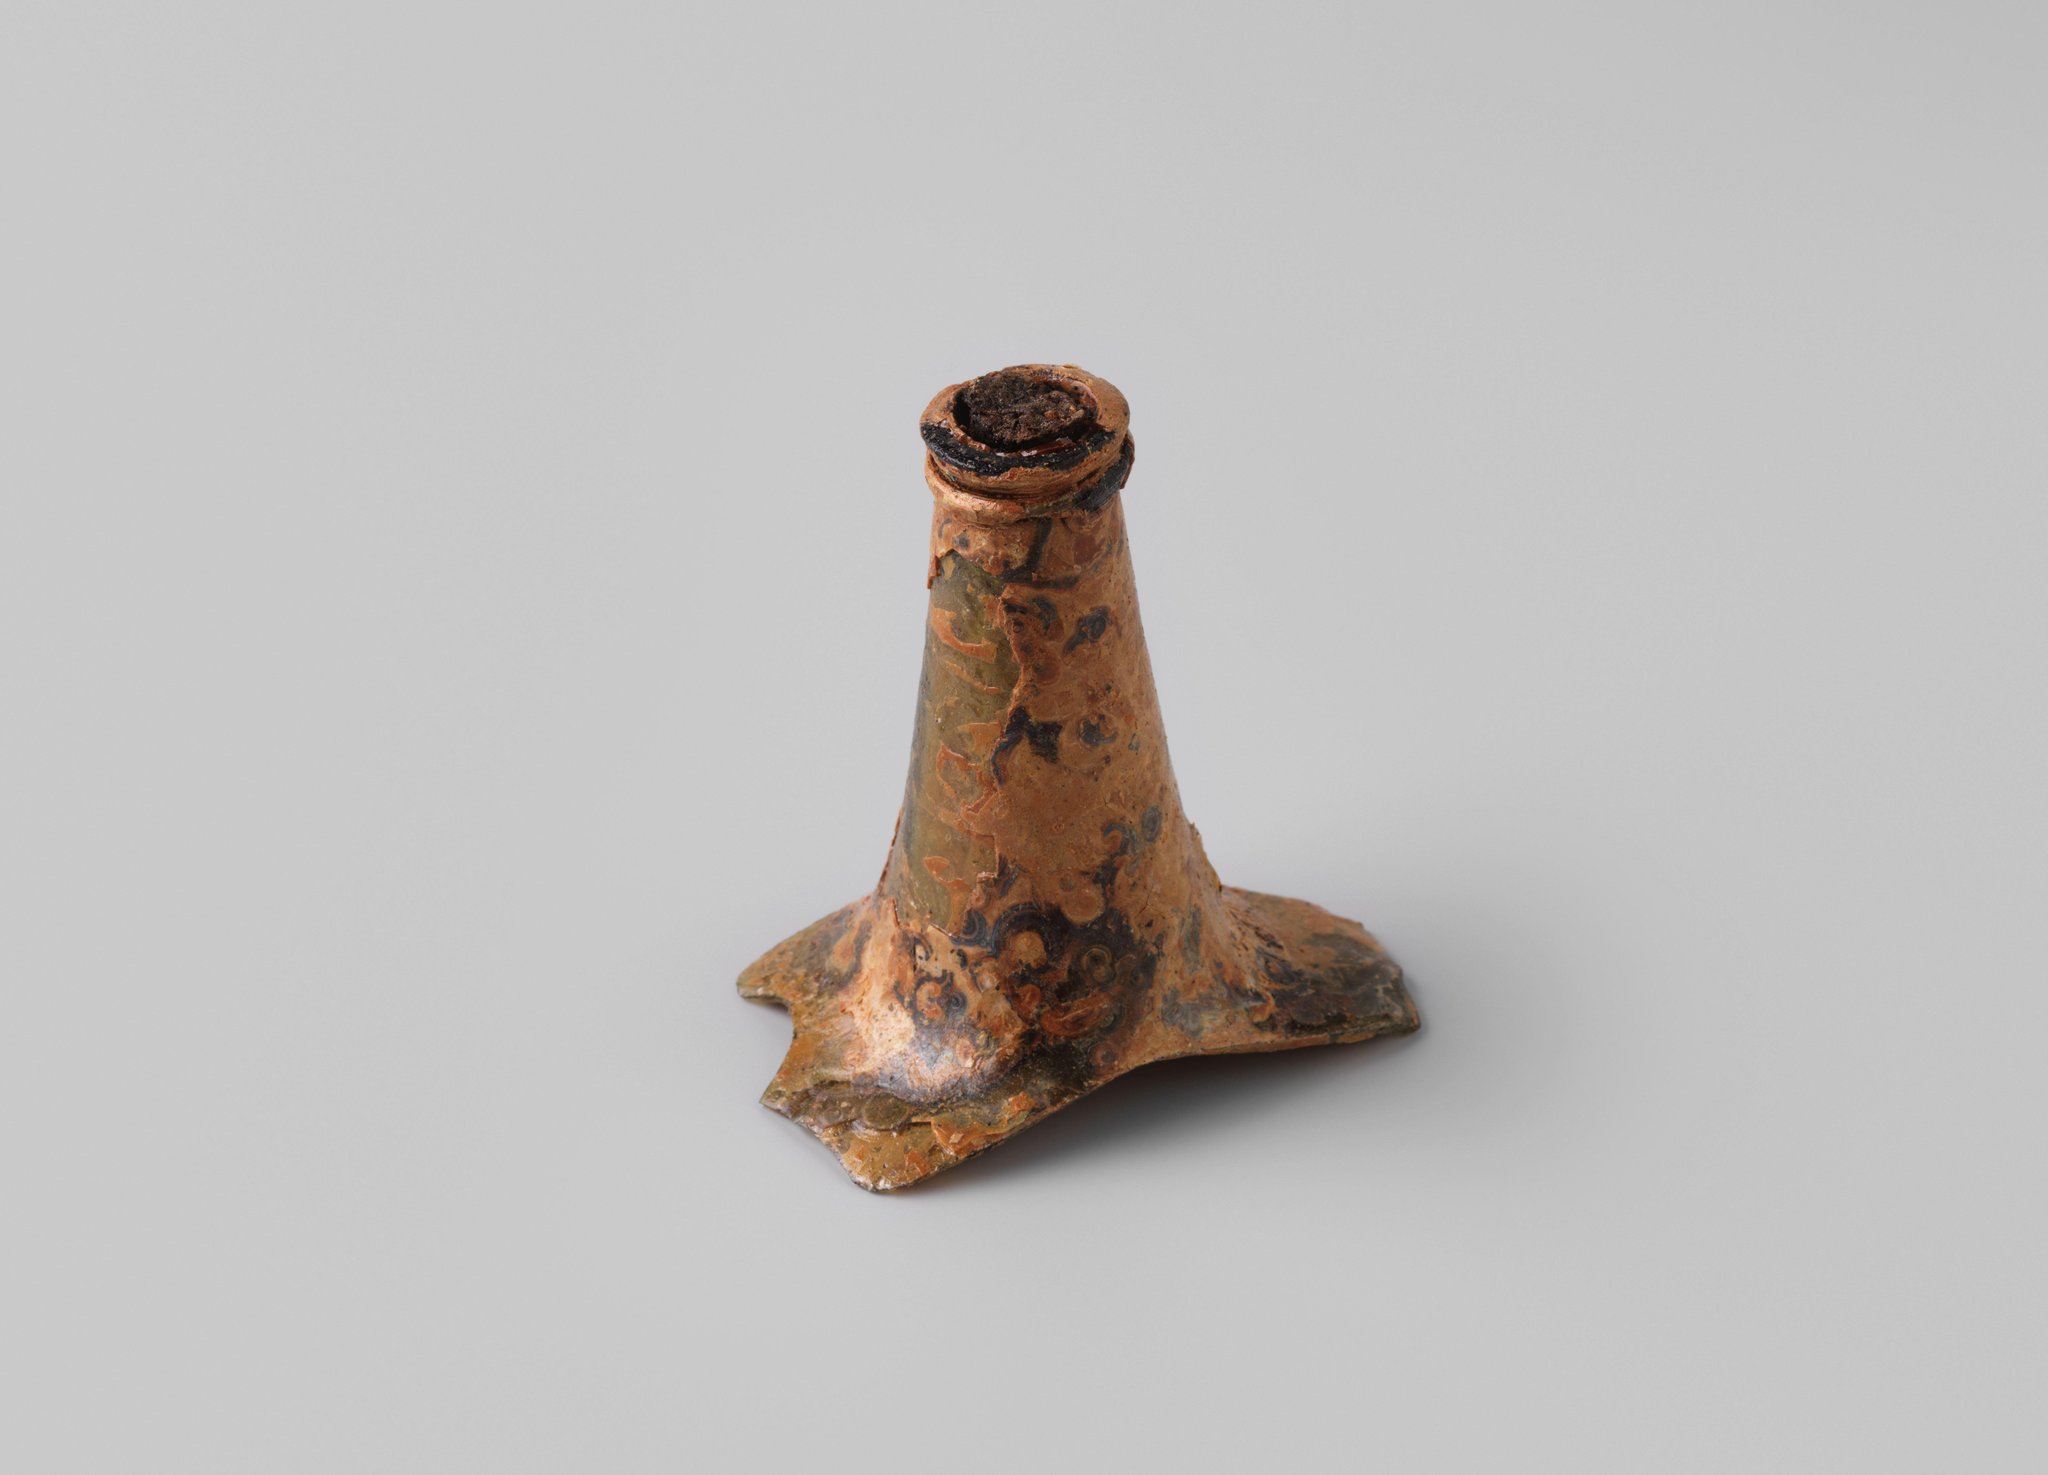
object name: sherd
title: Hals met kurk van een wijnfles uit het wrak van de Oost-Indiëvaarder Hollandia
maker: Anonymous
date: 1700-1743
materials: cork, glass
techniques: green glass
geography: netherlands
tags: verenigde oostindische compagnie, hollandia (schip), annet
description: Wine bottle, continental production, neck, onion-shaped bottle or bottle with vertical side; eroded, f-string rim, with cork.